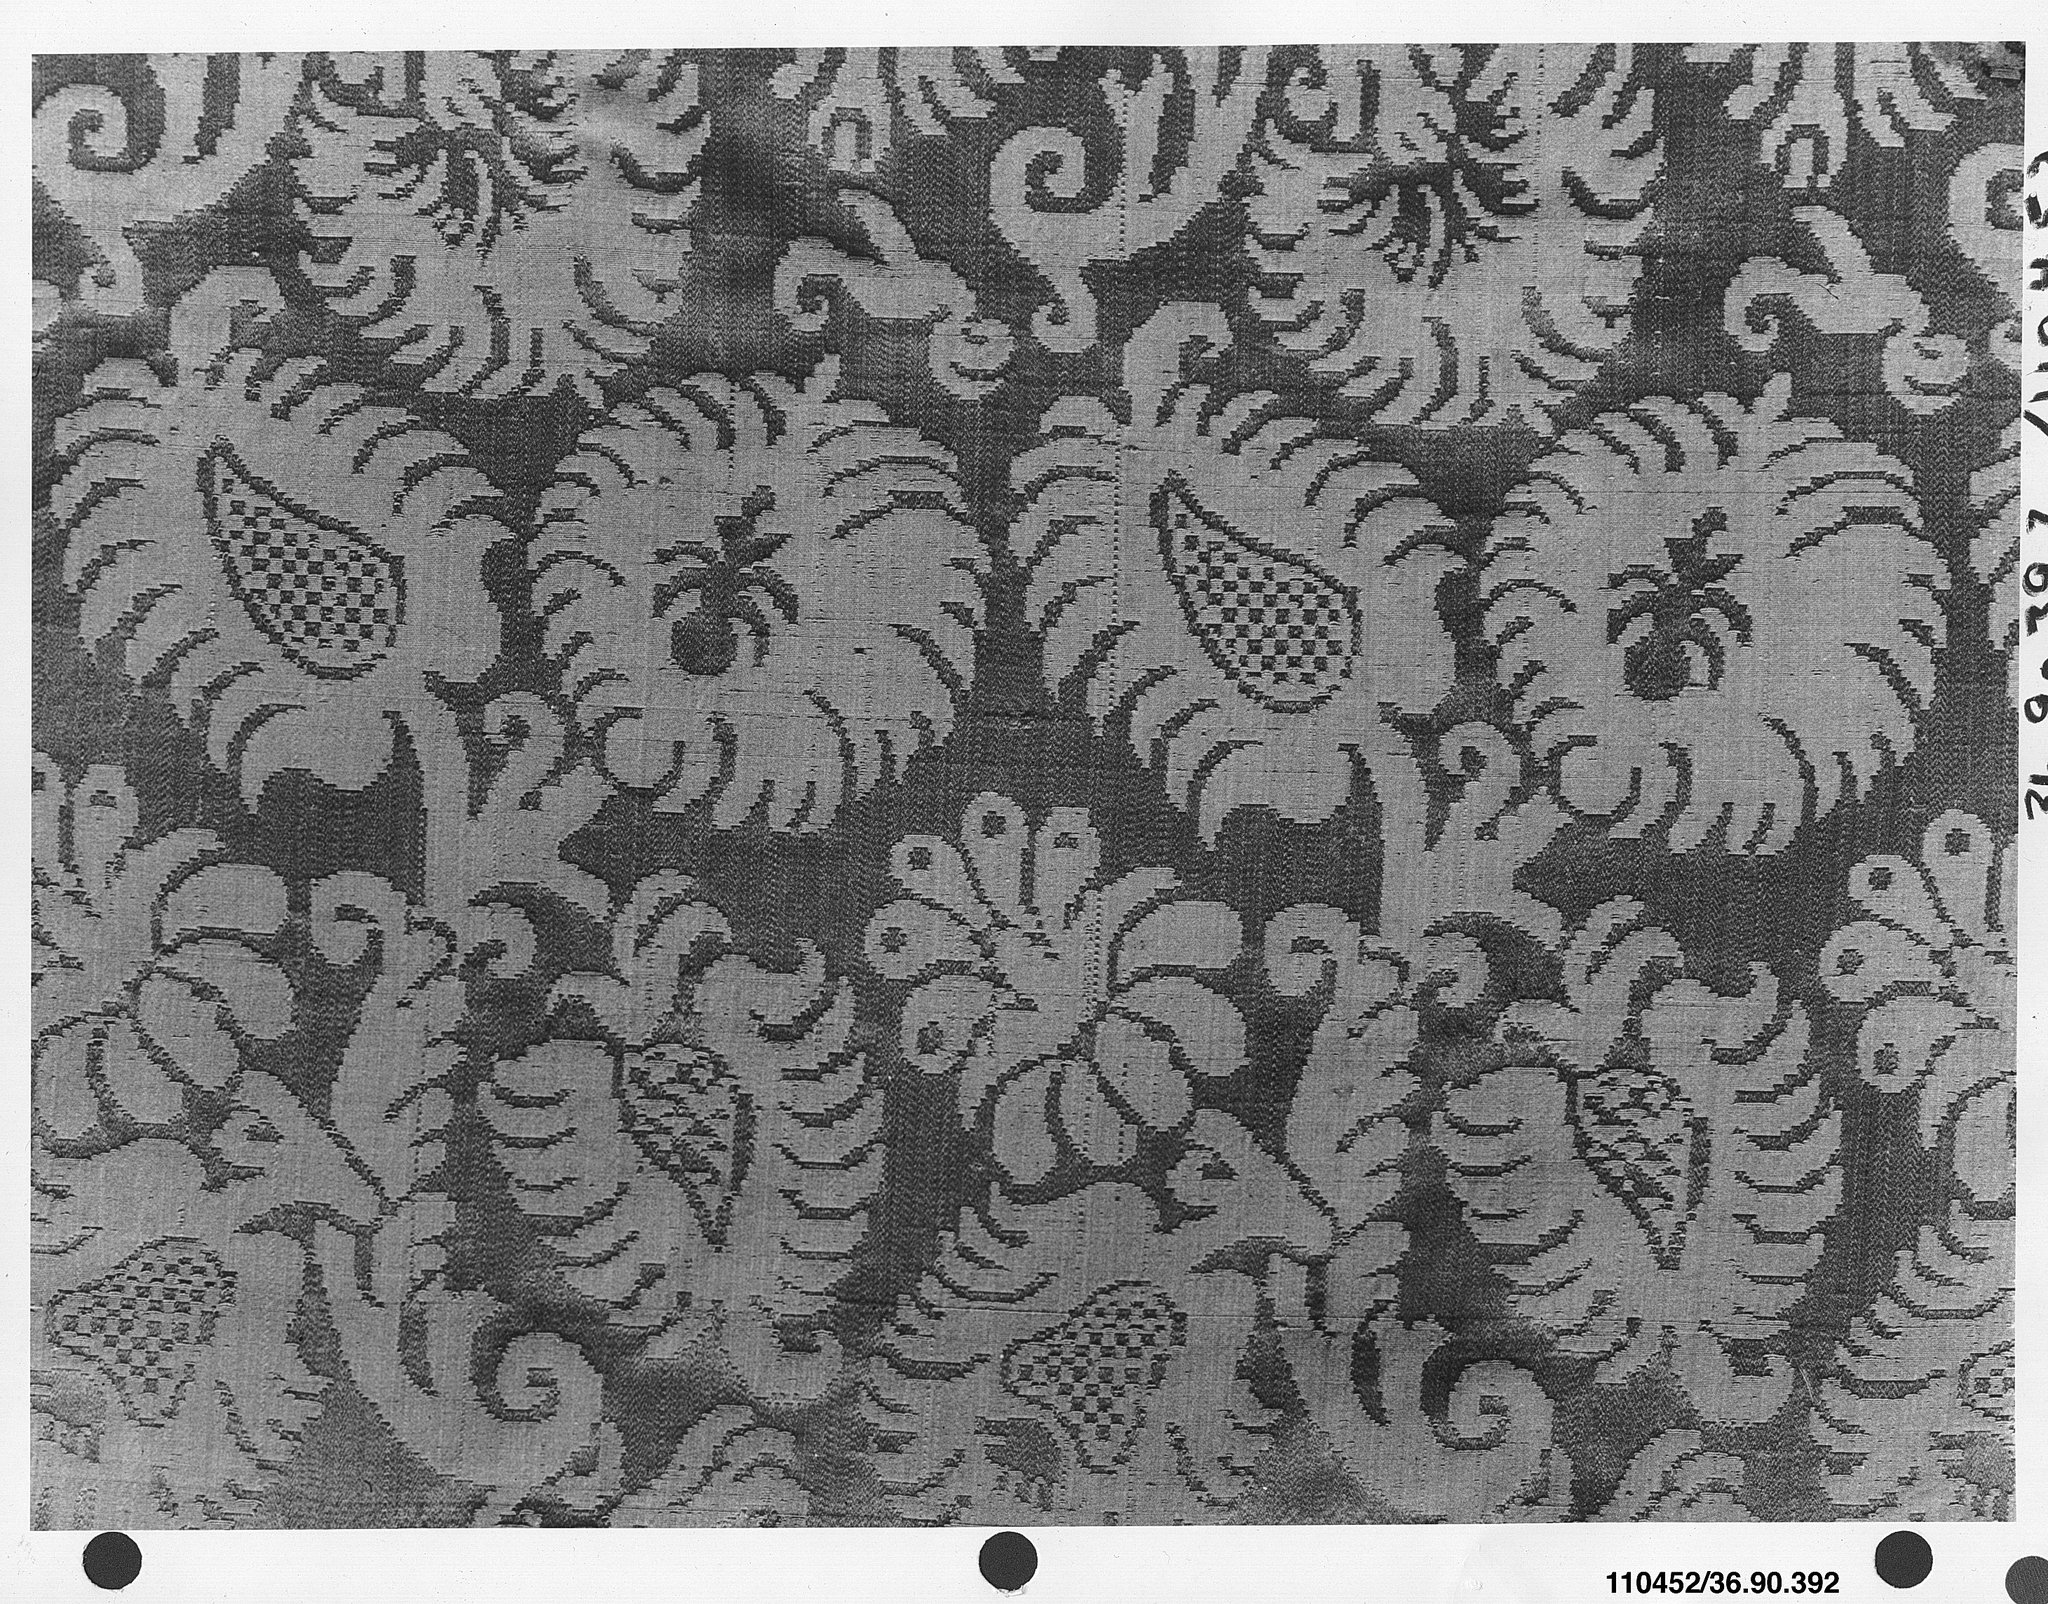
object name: piece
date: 1501-1700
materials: silk